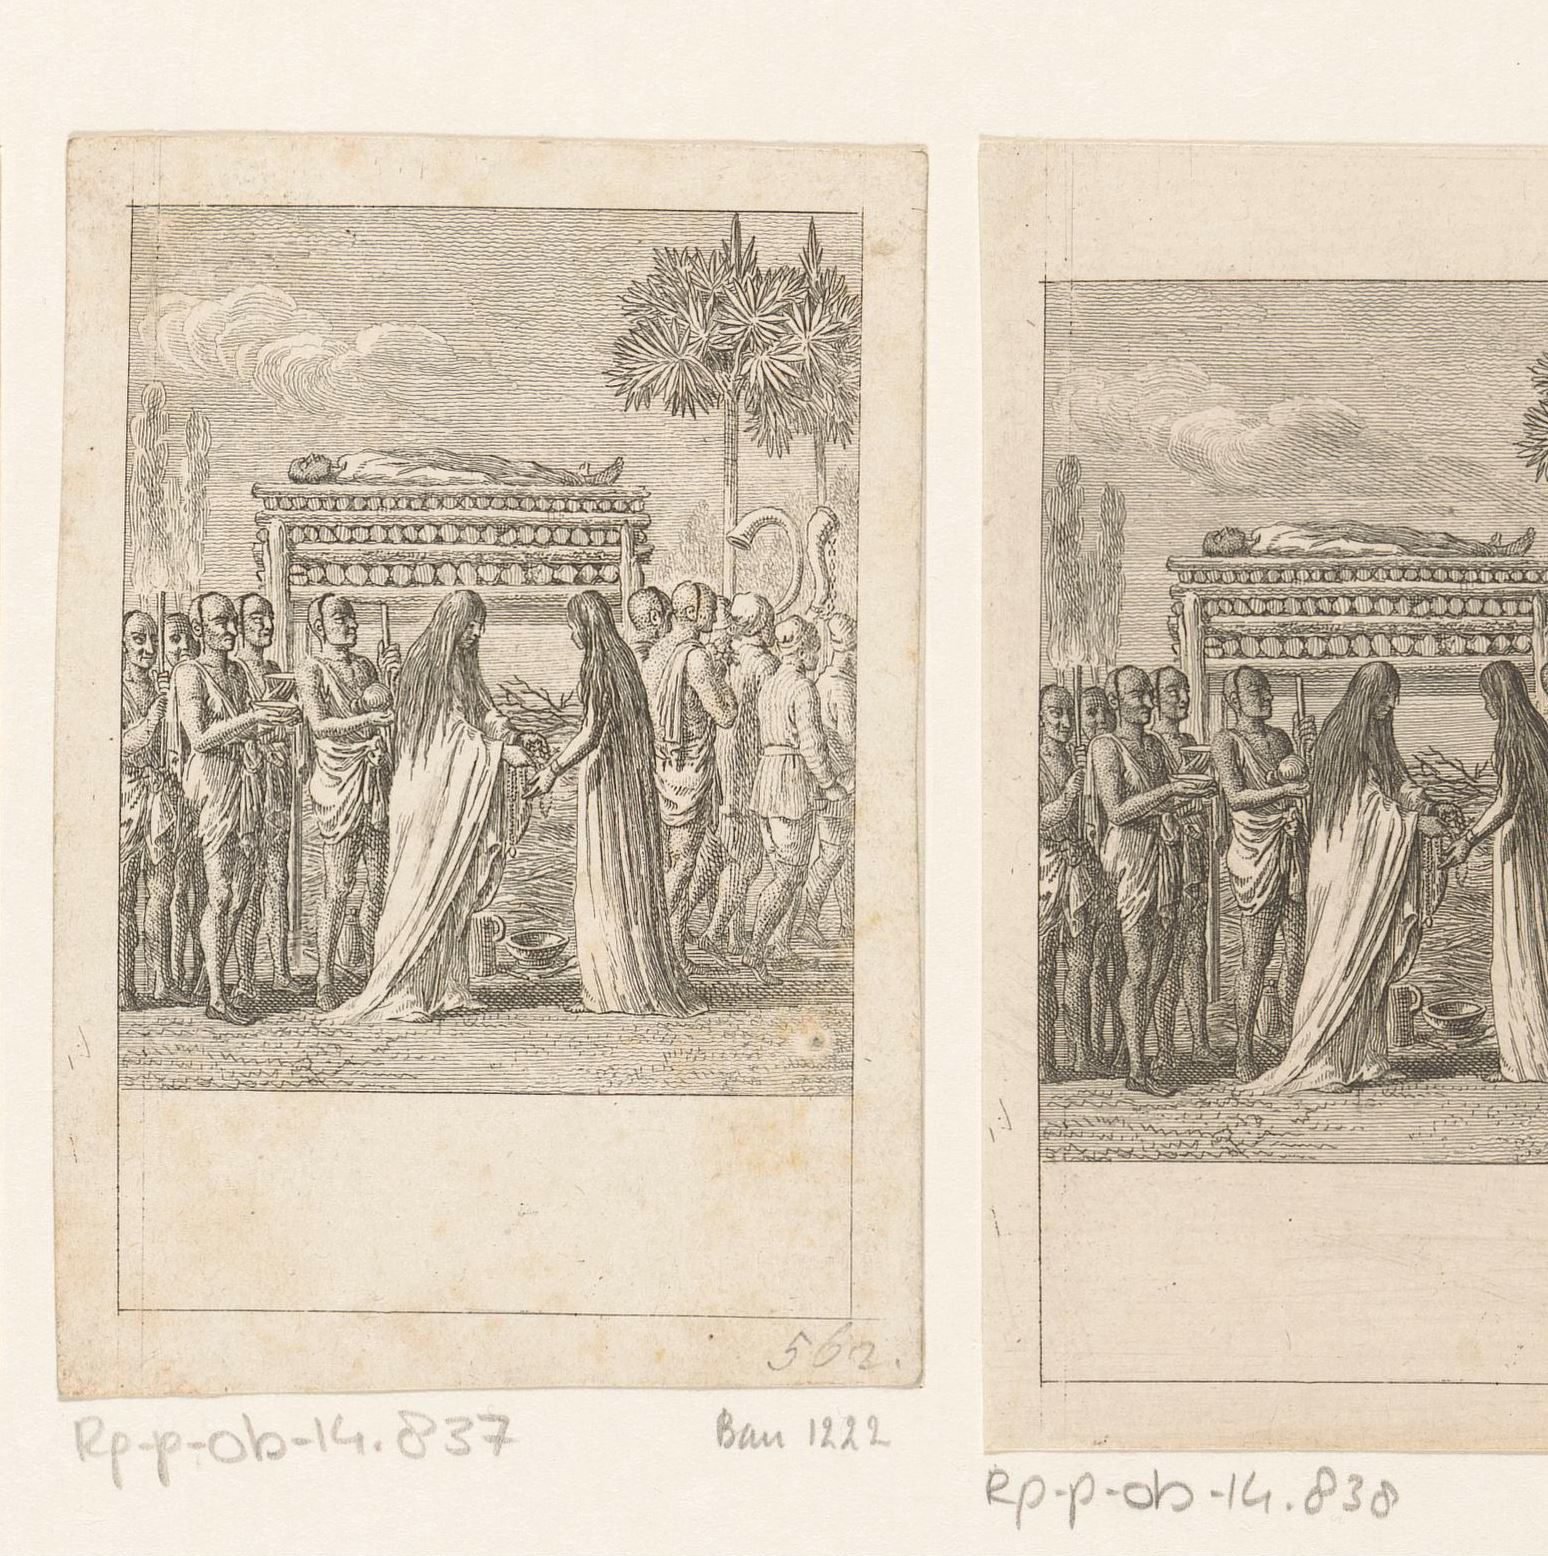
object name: print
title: Vrijwillige verbranding van de weduwe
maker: daniel nikolaus chodowiecki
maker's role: draughtsman, print maker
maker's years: 1726-1801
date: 1786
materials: paper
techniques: etching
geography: berlin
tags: human sacrifice ~ non-christian religions, widow, asiatic races and peoples: indians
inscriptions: collector's mark: Lugt 2228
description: Latere staat gebruikt voor: Sprengel, Matthias Christian. Historisch-genealogischer Calender, oder, Jahrbuch der merkwürdigsten neuen Welt-Begebenheiten für 1786. Leipzig: Zur Messe bey Haude und Spener von Berlin, s.a.